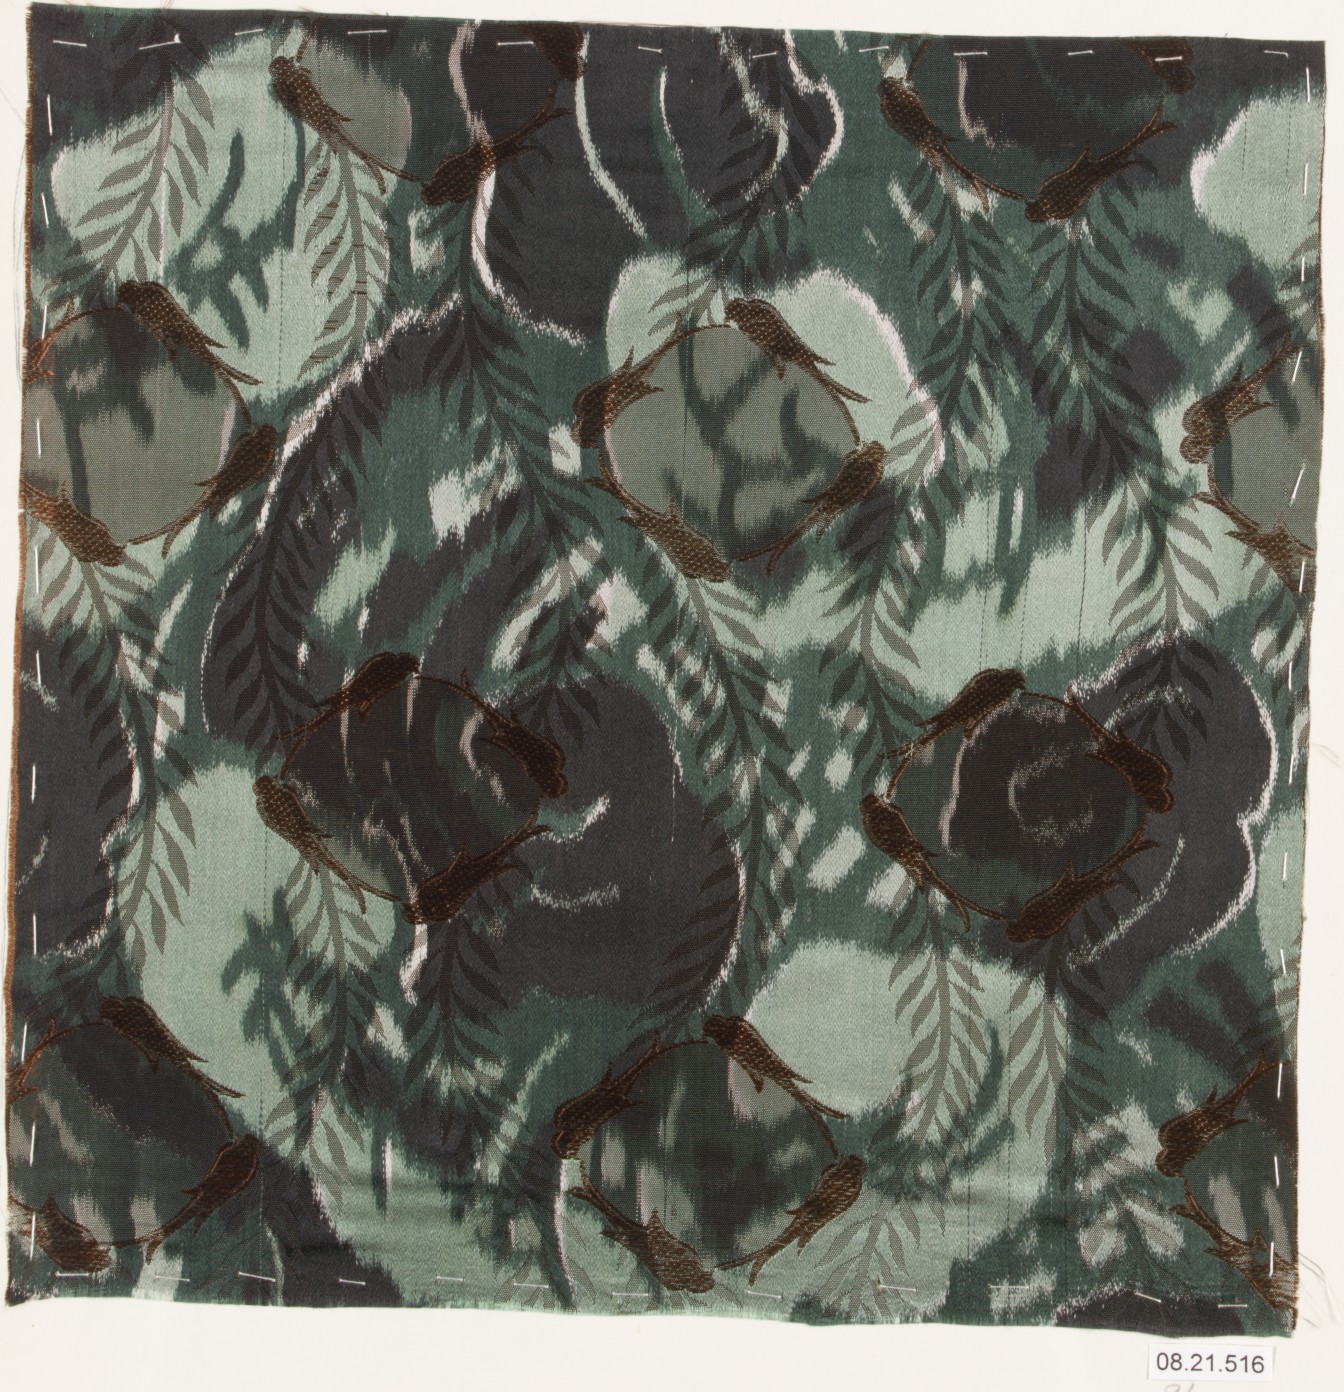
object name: textile sample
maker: Anonymous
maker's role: designer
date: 1900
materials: silk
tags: leaves